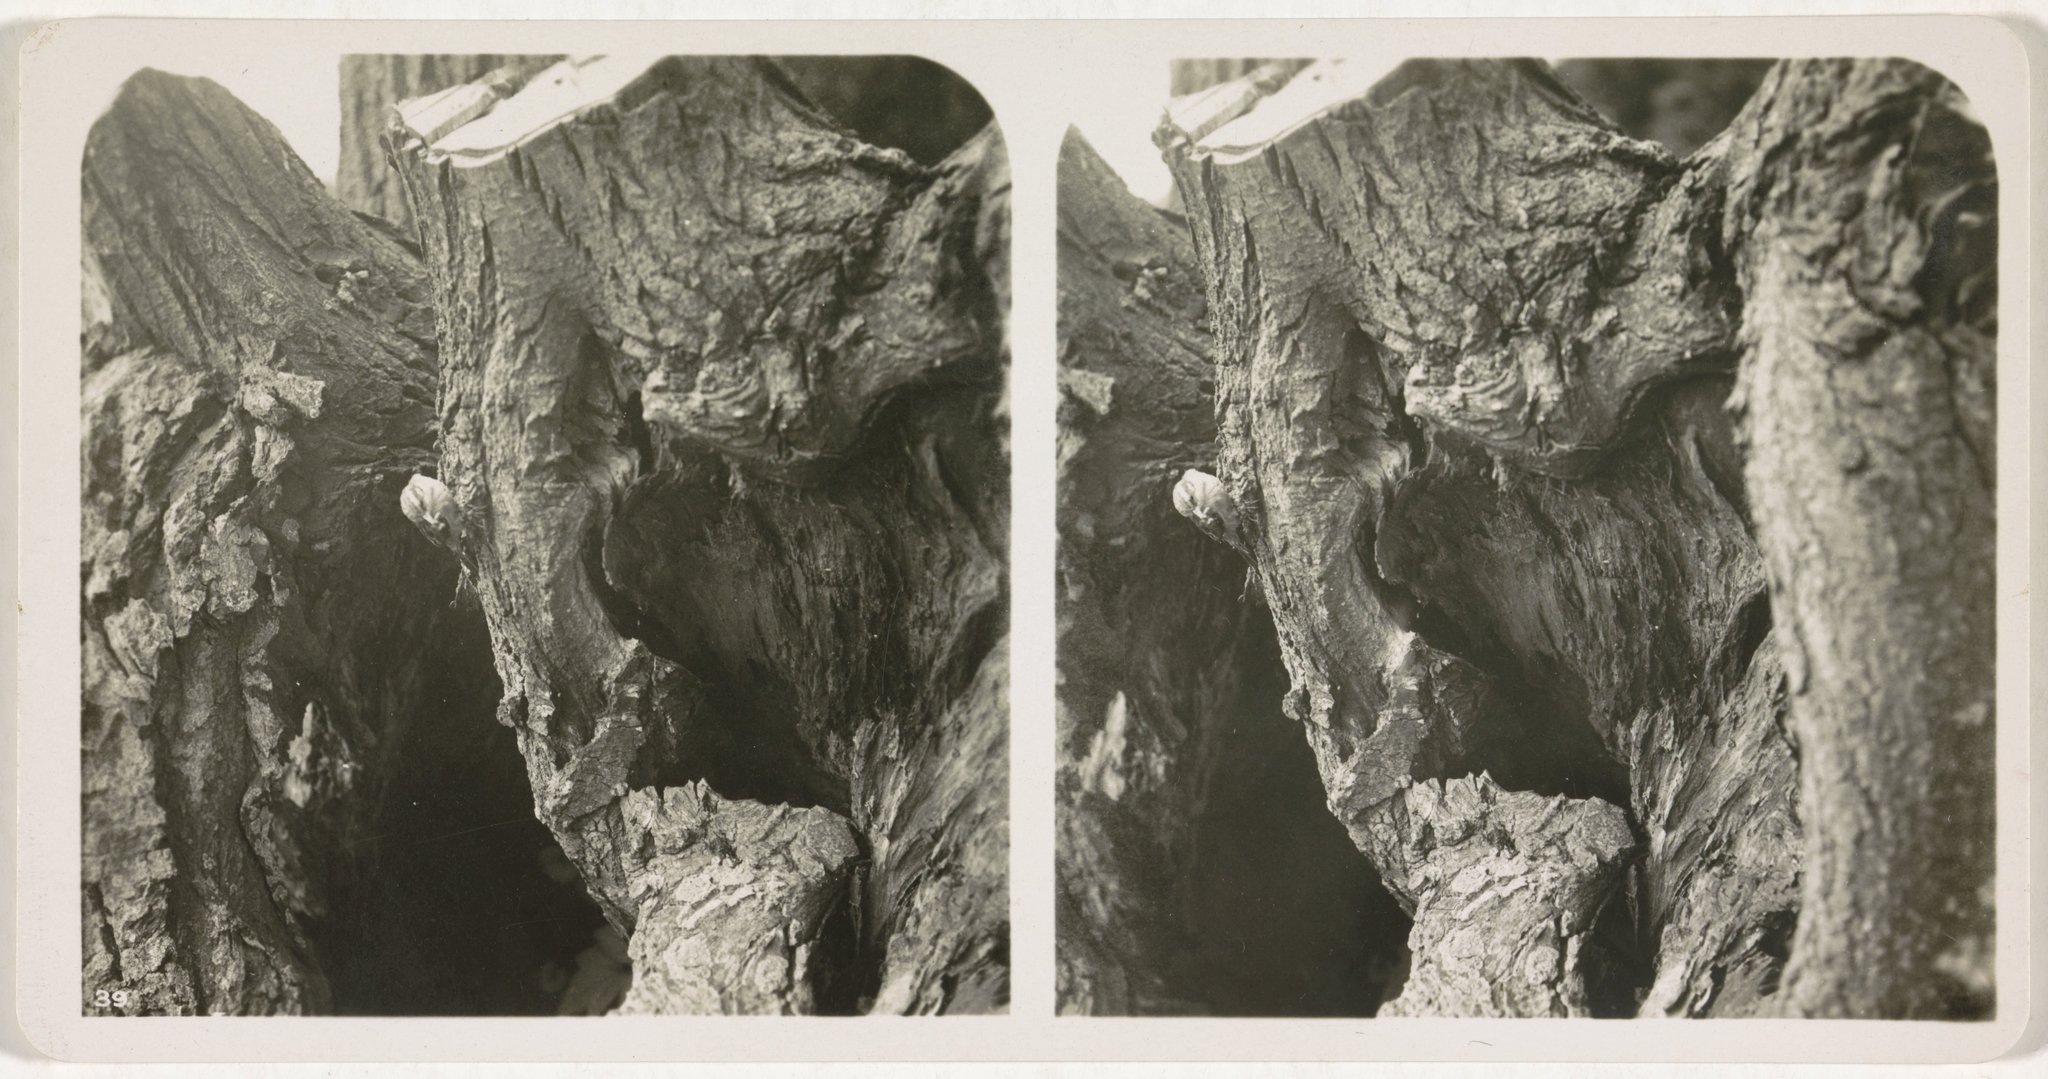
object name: stereograph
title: Les oiseaux et leurs nids / 2e Série Les oiseaux chanteurs (Suite).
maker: adolphe burdet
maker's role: fotograaf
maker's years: 1860-1940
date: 1870-1940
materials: photographic support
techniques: gelatin silver print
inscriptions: label: ‘39 / Certhia familiaris Temminck / Grimpereau / Boomkruiper’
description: Linksonder op de foto links staat het nummer 39. Uit serie van 25 stereofoto's.